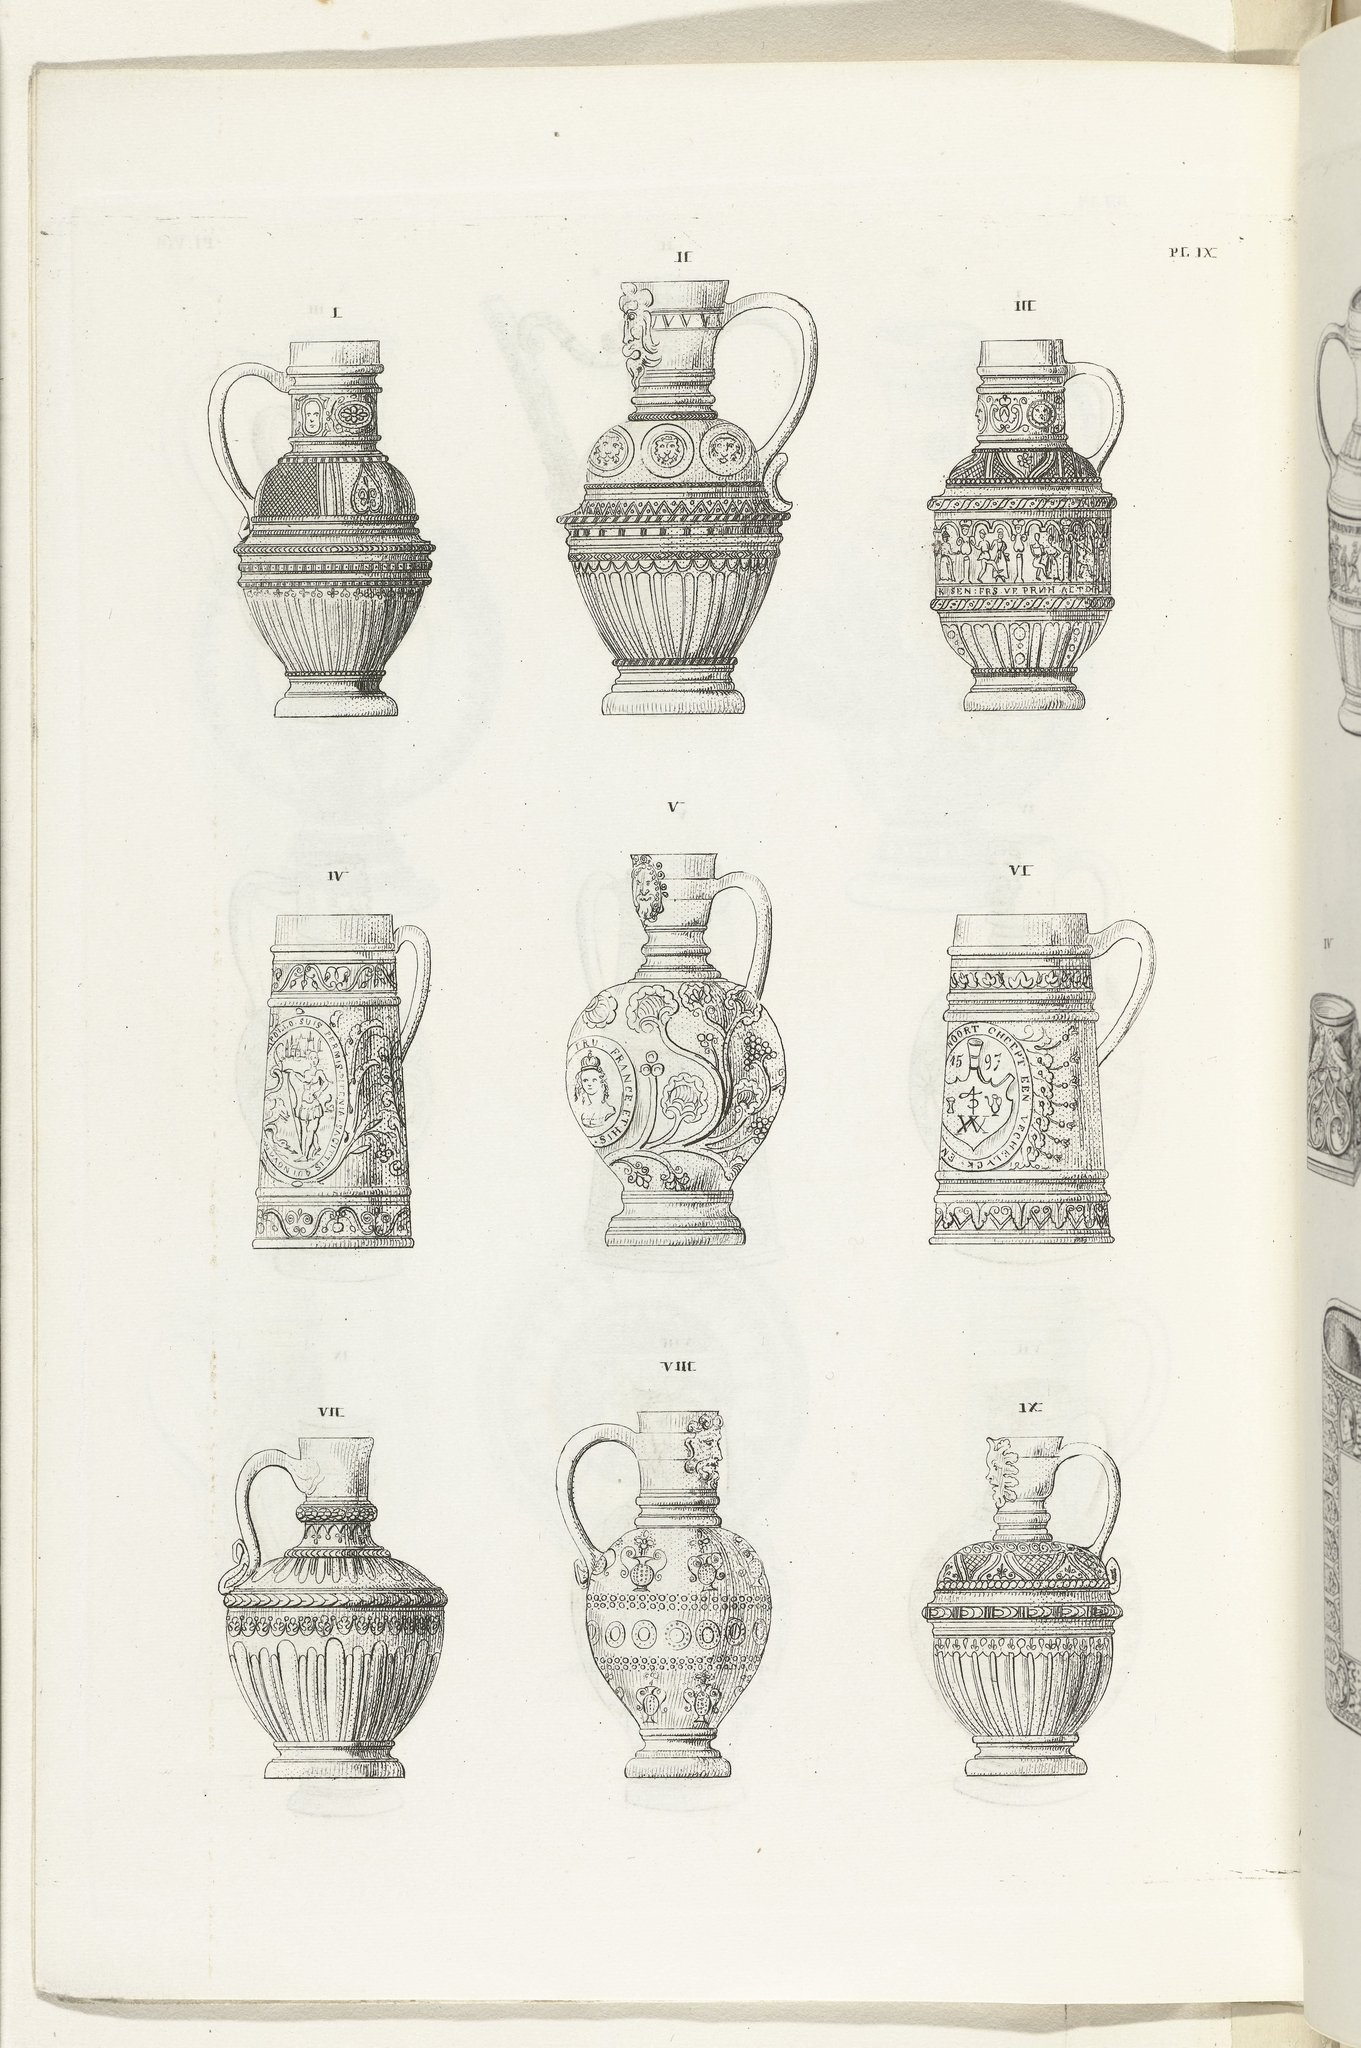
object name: print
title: Kannen van steengoed, plaat IX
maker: charles onghena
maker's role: print maker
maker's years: 1806-1886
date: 1827-1829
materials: paper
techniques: etching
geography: belgium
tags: container of ceramics: jar, jug, pot, vase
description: Onderdeel van illustraties in: Objects Rares recueillis et publiés par Joan. D'Huyvetter, P.F. Goesin-Verhaeghe, Gent 1829, plaat IX. Deze Franstalige editie bevat dezeflde platen als de Nederlandse maar is kleiner van formaat, dubbelzijdig bedrukt en zonder de inleiding. Ingebonden achterin de Nederlandstalige uitgave van hetzelfde werk: Zeldzaamheden verzameld en uitgegeven door Joan. D'Huyvetter. In het exemplaar in de collectie van de Rijksmuseum Research Library (15 D 38).